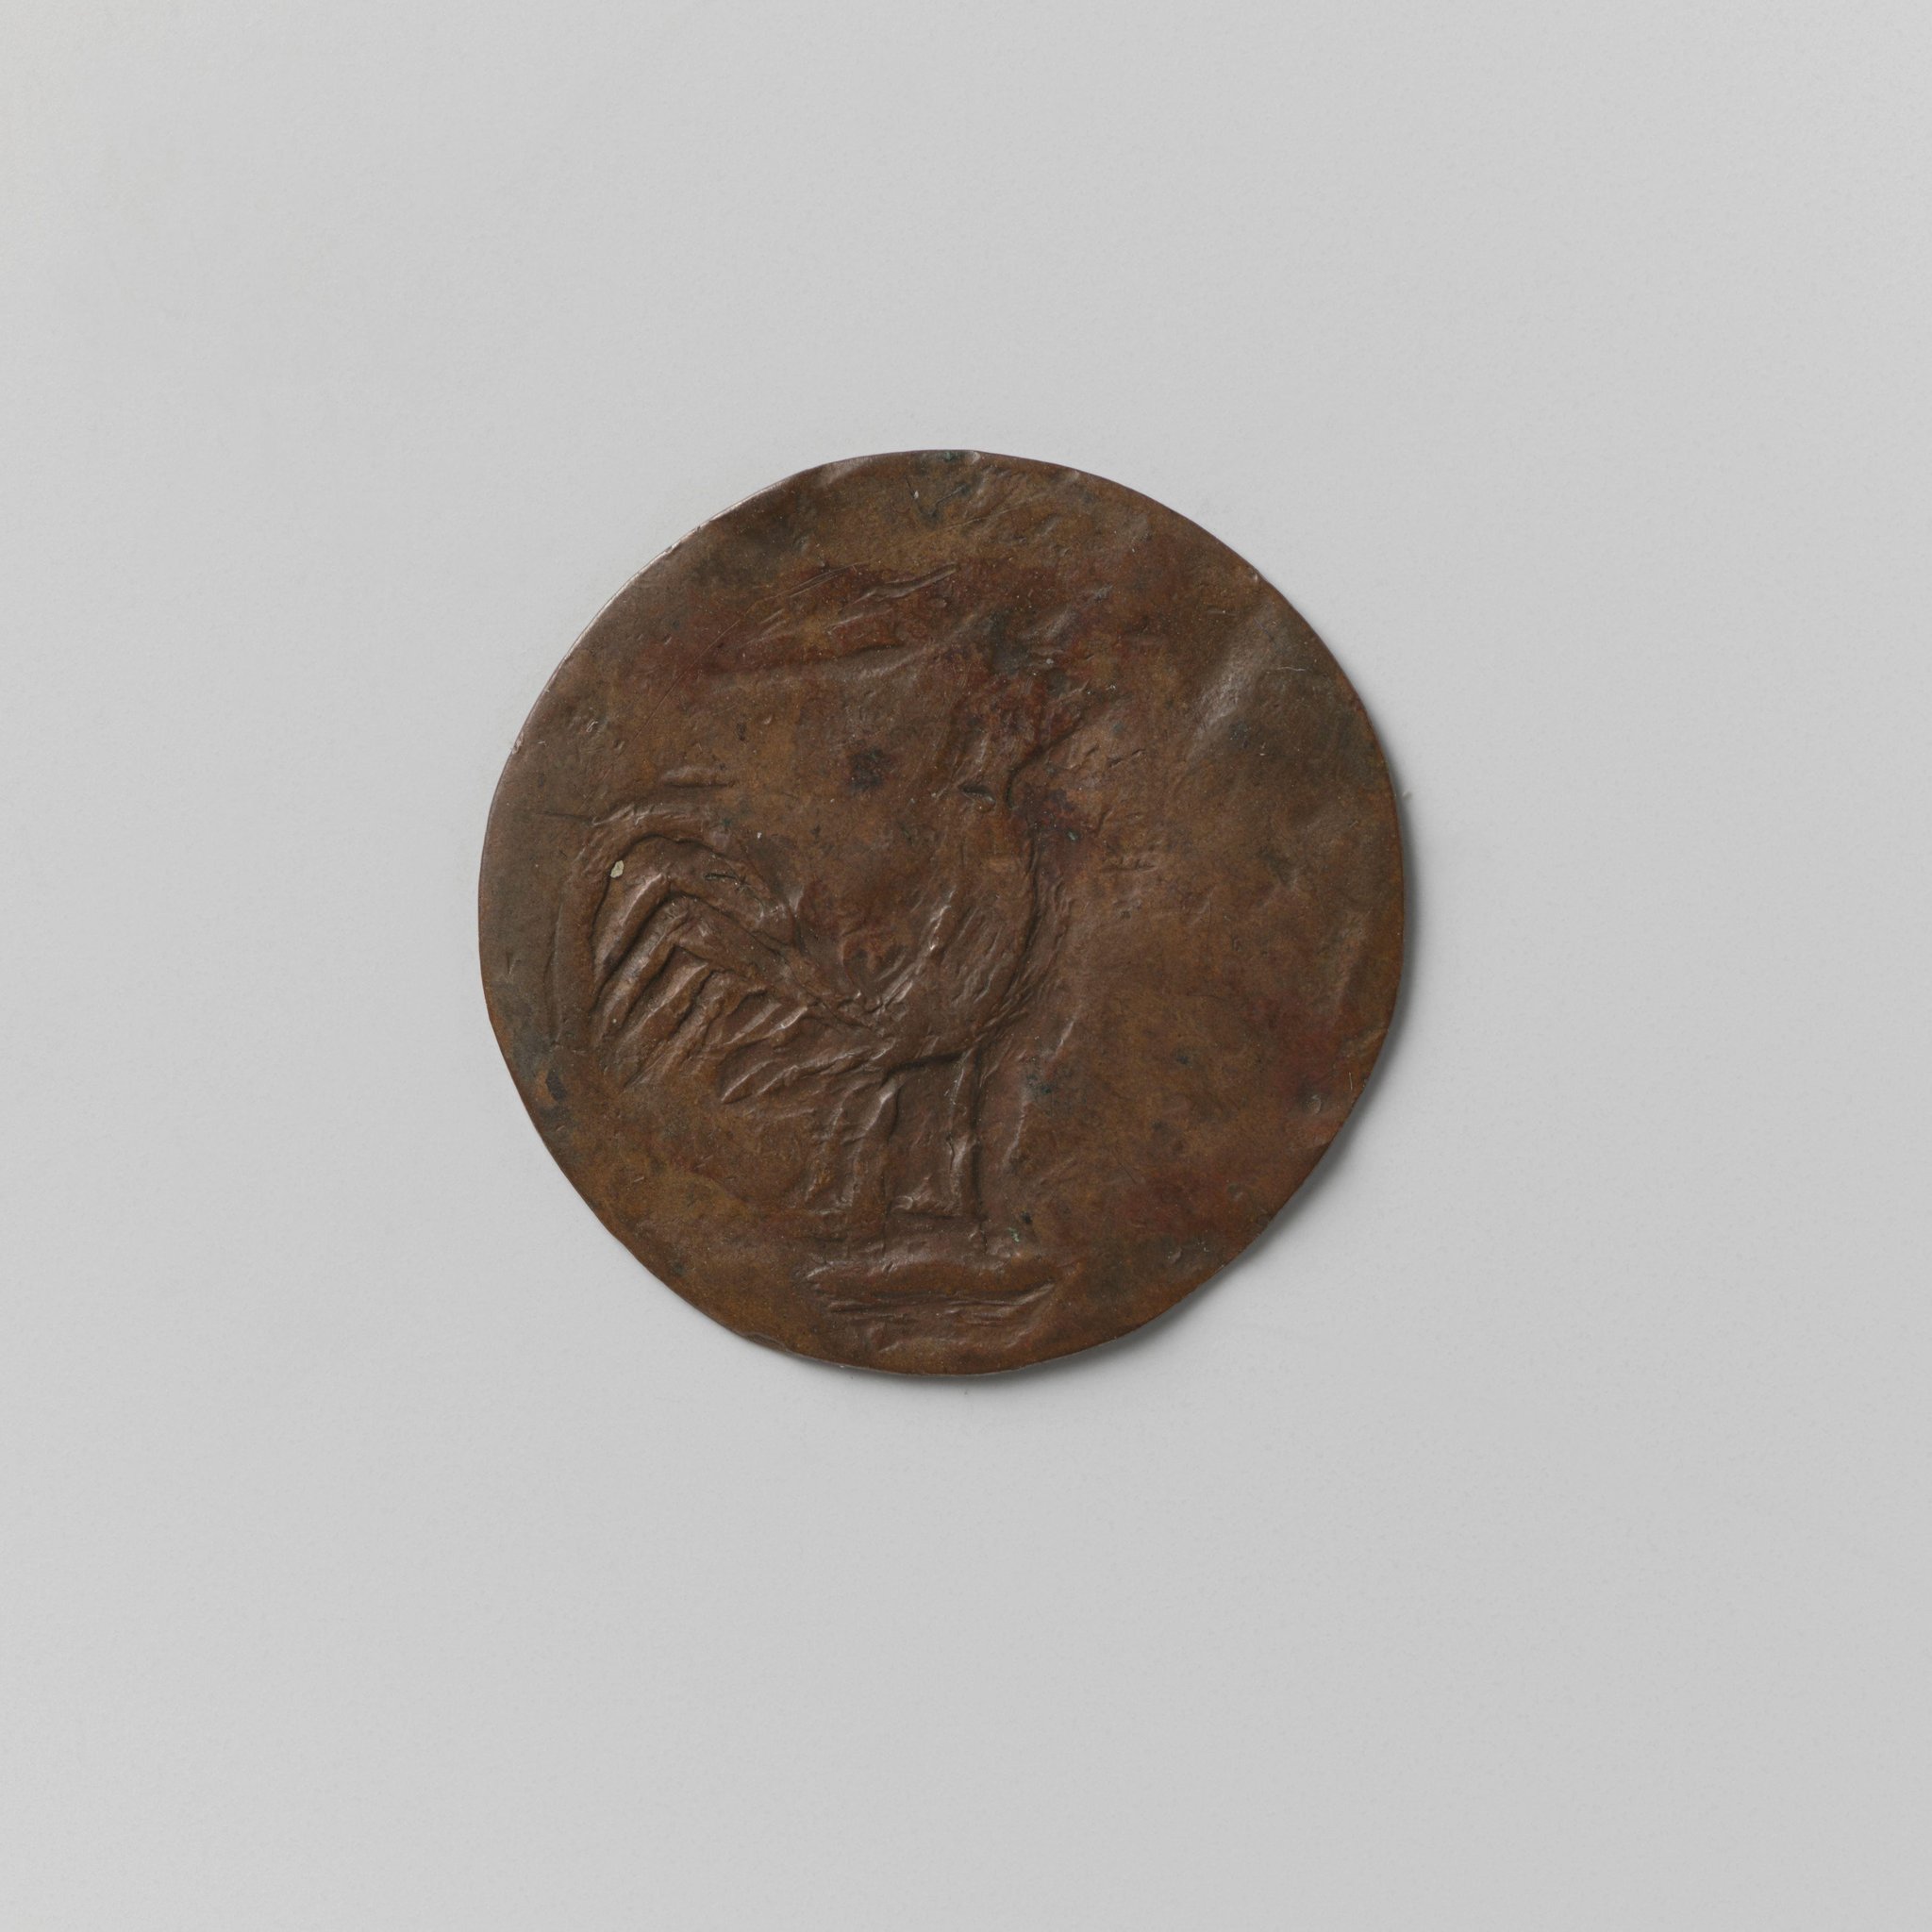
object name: coin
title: Nabootsing van een haantjesduit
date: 1780-1830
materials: copper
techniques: striking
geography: banjarmasin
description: Koperen munt. Nabootsing van een haantjesduit. Voorzijde: haan naar rechts. Keerzijde: niet te ontcijferen tekens.